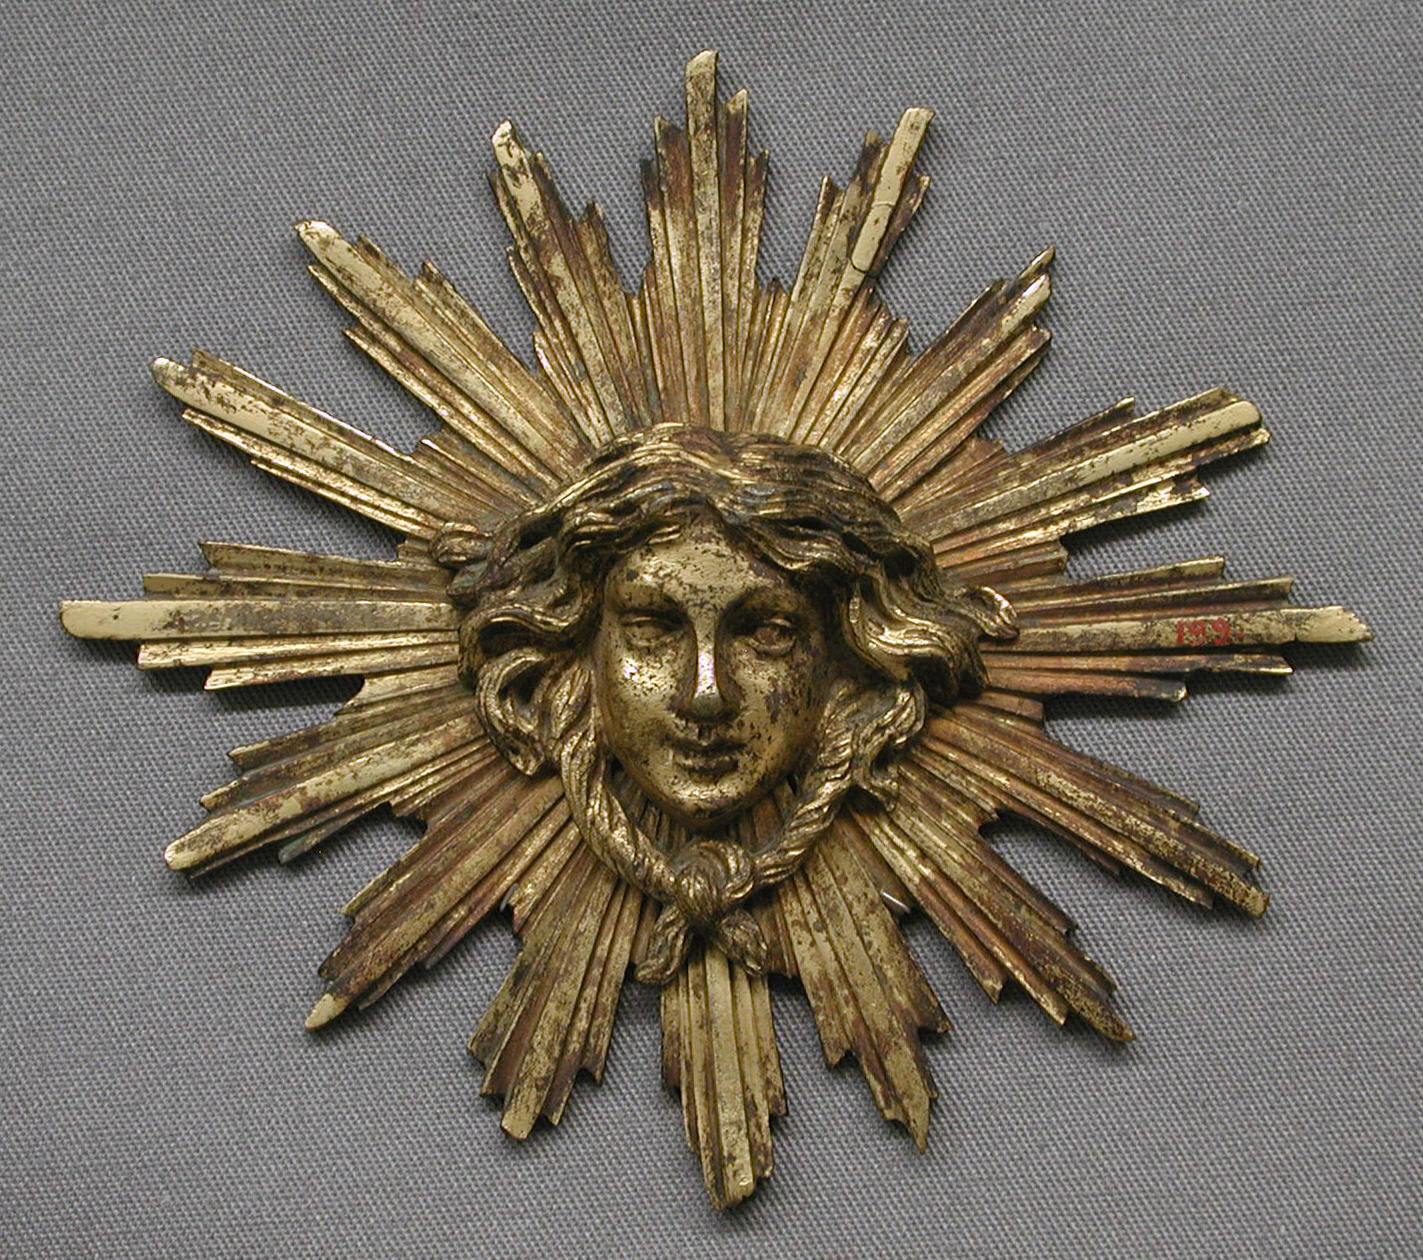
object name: clock ornament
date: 1701-1800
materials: gilt bronze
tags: faces